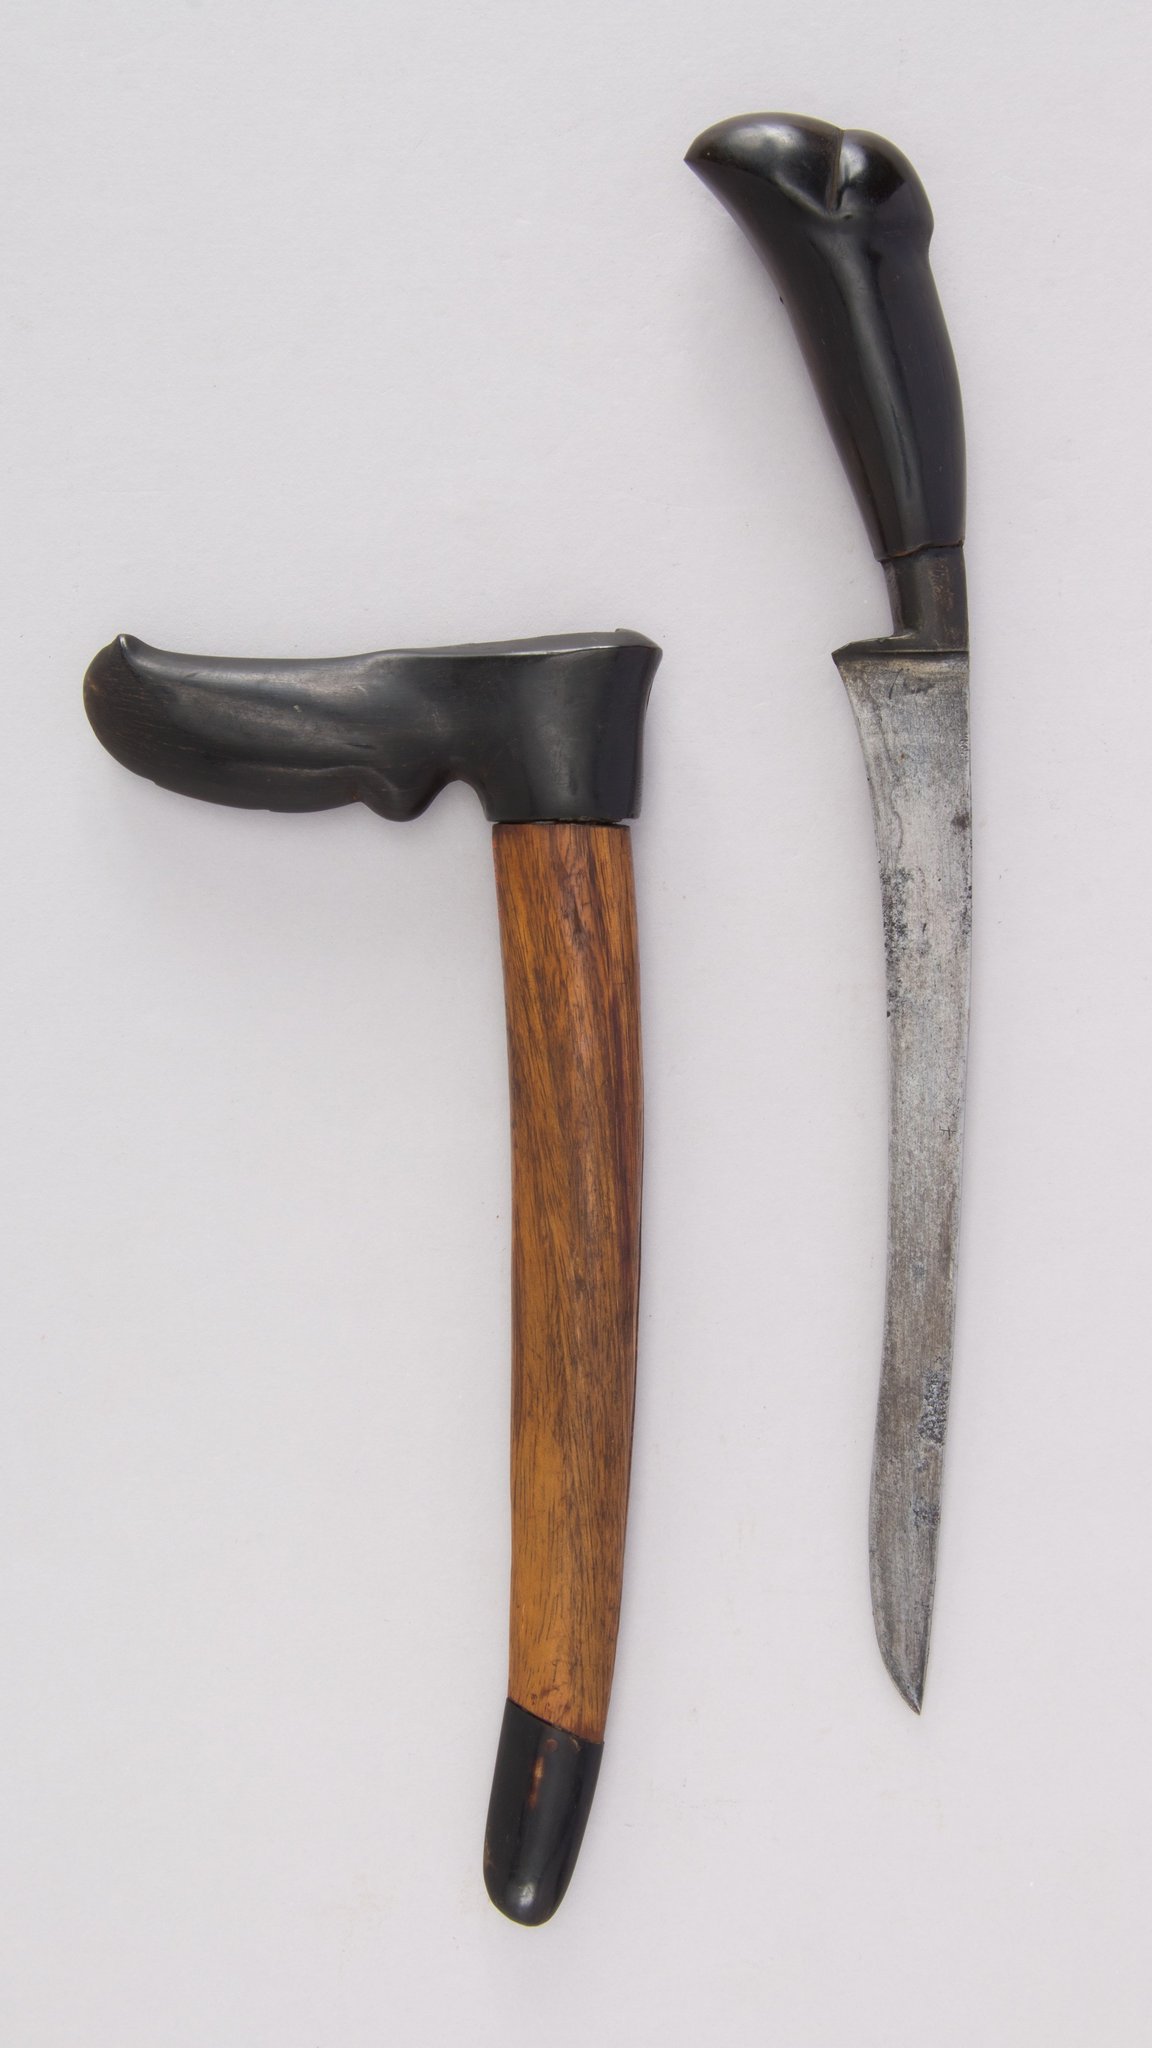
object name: knife bade bade with sheath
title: Knife (Bade-bade) with Sheath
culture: indonesian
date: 1701-1900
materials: horn, steel, wood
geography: indonesia